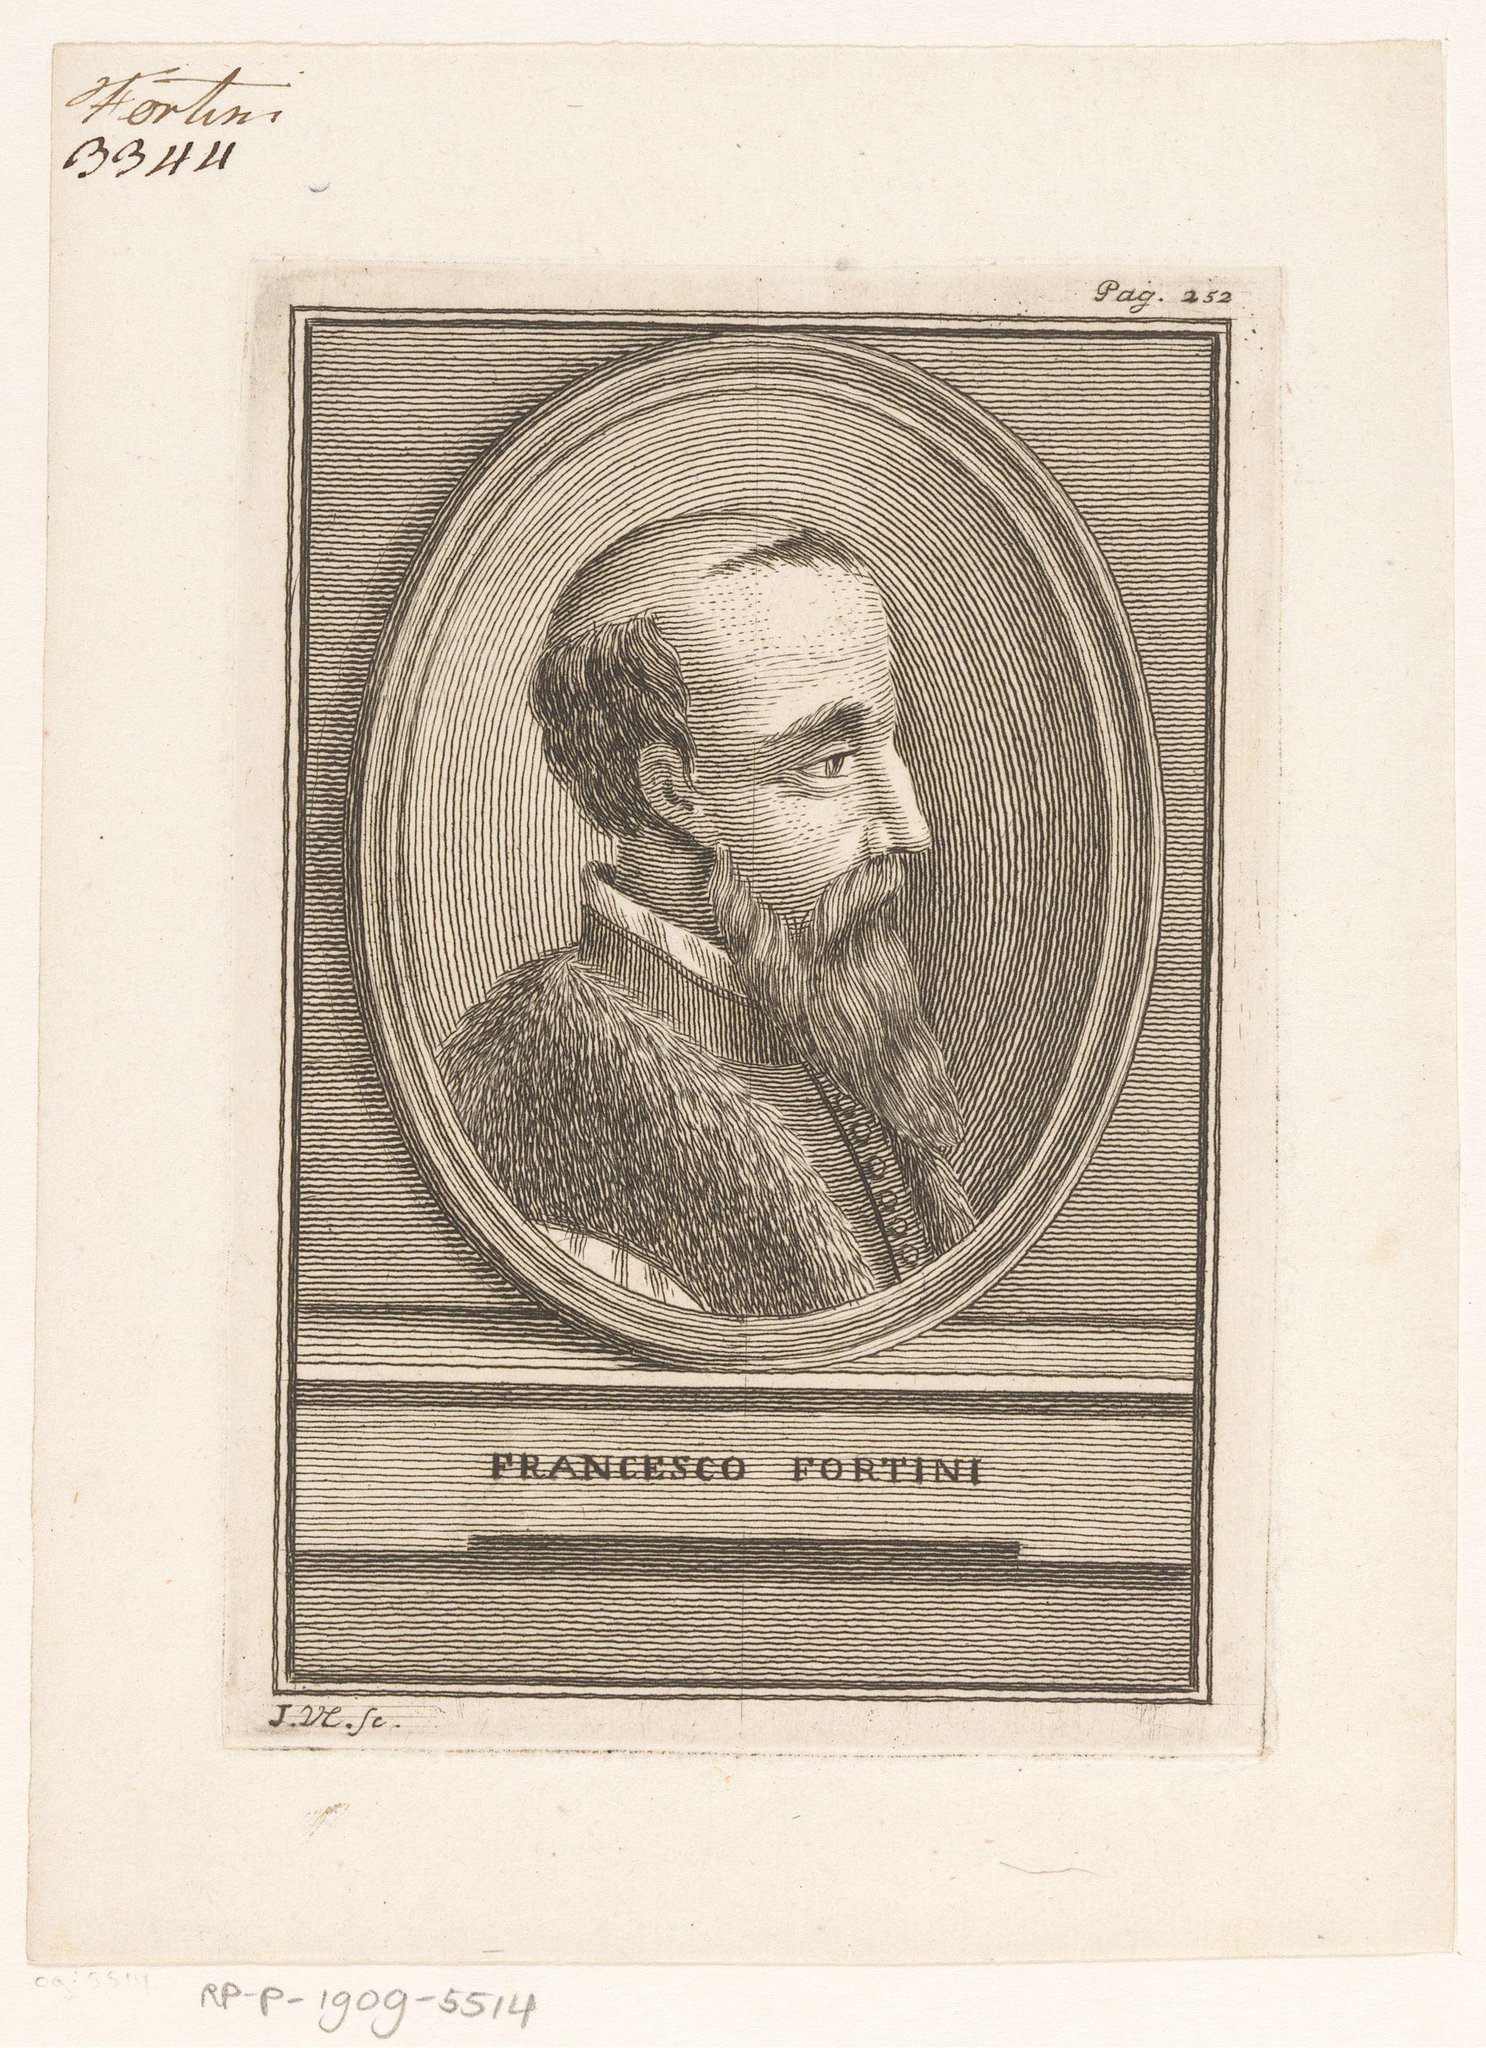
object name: book illustration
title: Portret van liedschrijver Francesco Fortini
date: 1750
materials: paper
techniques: engraving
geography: lucca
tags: historical persons, portrait of a writer, writer, poet, author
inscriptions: collector's mark: Lugt 2228, inscription: ‘Fortini / 3344’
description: Prent gebruikt voor Grazzini, Anton Francesco. Tutti i trionfi, carri, mascherate o canti carnascialeschi andati per Firenze dal tempo del Magnifico Lorenzo de' Medici fino all' anno 1559 : in questa seconda edizione corretti, con diversi MSS. collazionati, delle loro varie lezioni arricchiti, notabilmente accresciuti, e co' ritratti di ciascun poeta adornate. Lucca: Cosmopoli, 1750.